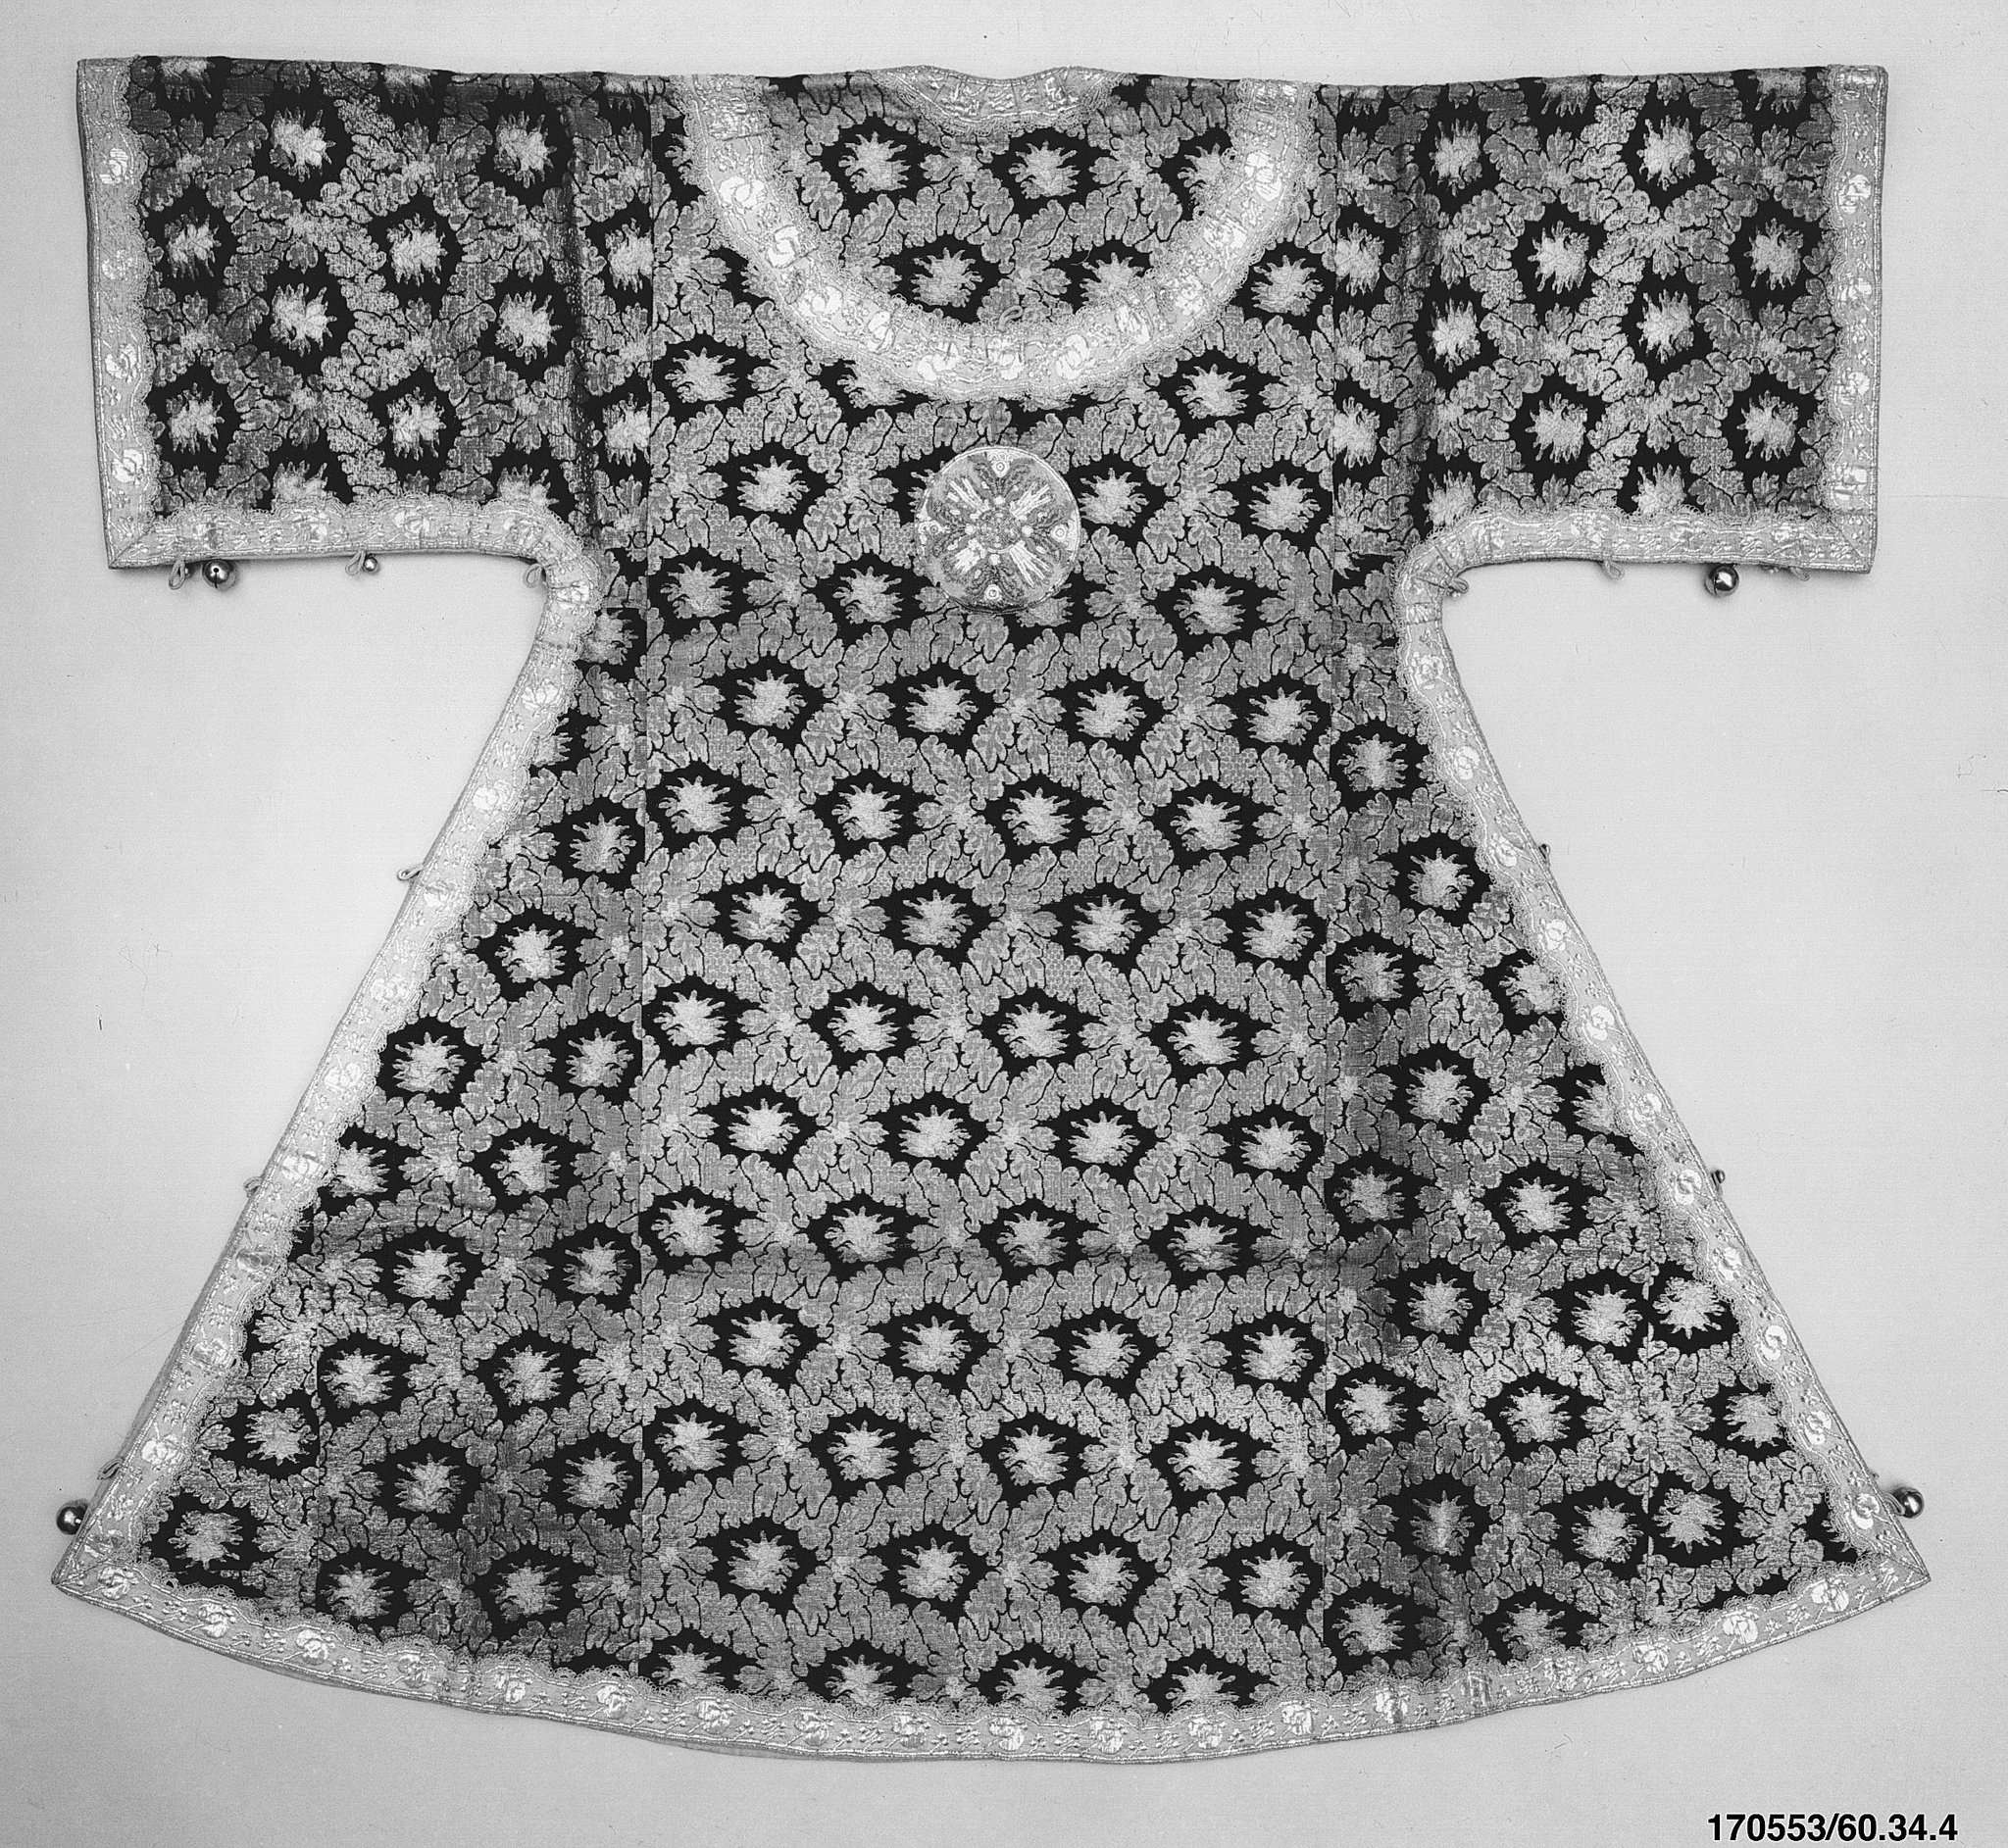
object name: sacco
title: Saccos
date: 1805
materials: metal thread, silk